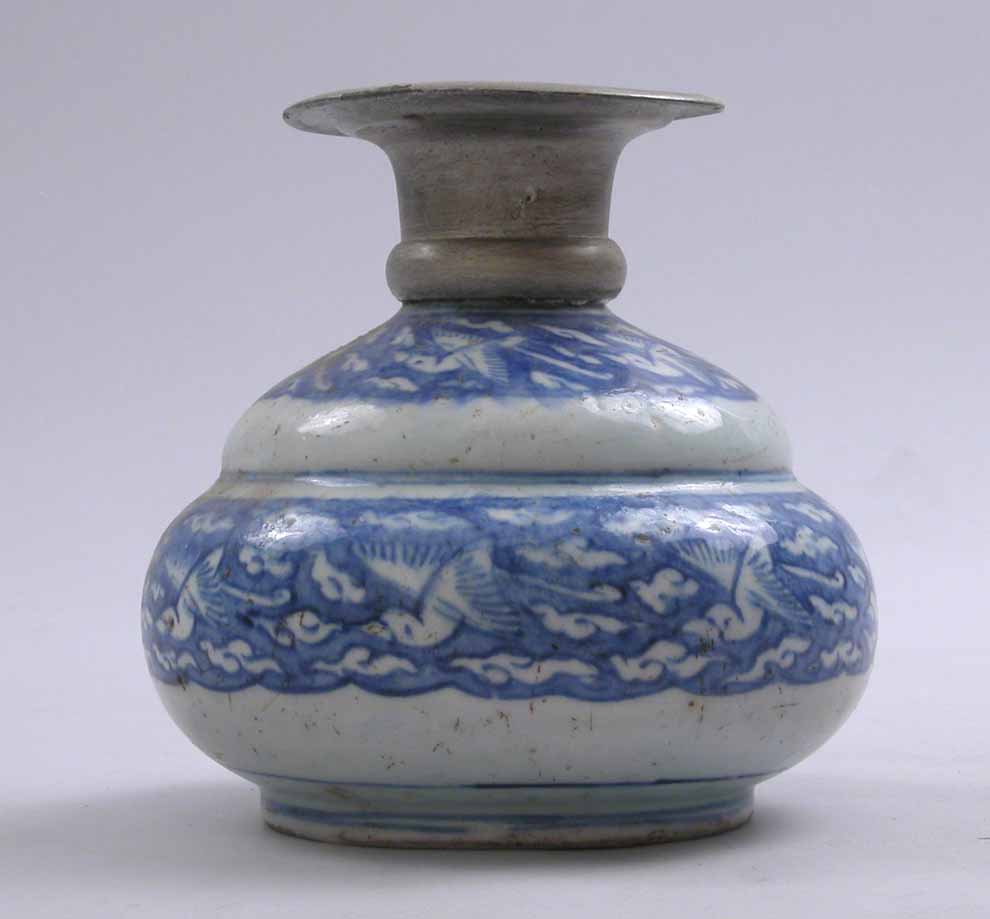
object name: bottle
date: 1601-1700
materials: copper alloy, glaze, stonepaste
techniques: painting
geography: iran